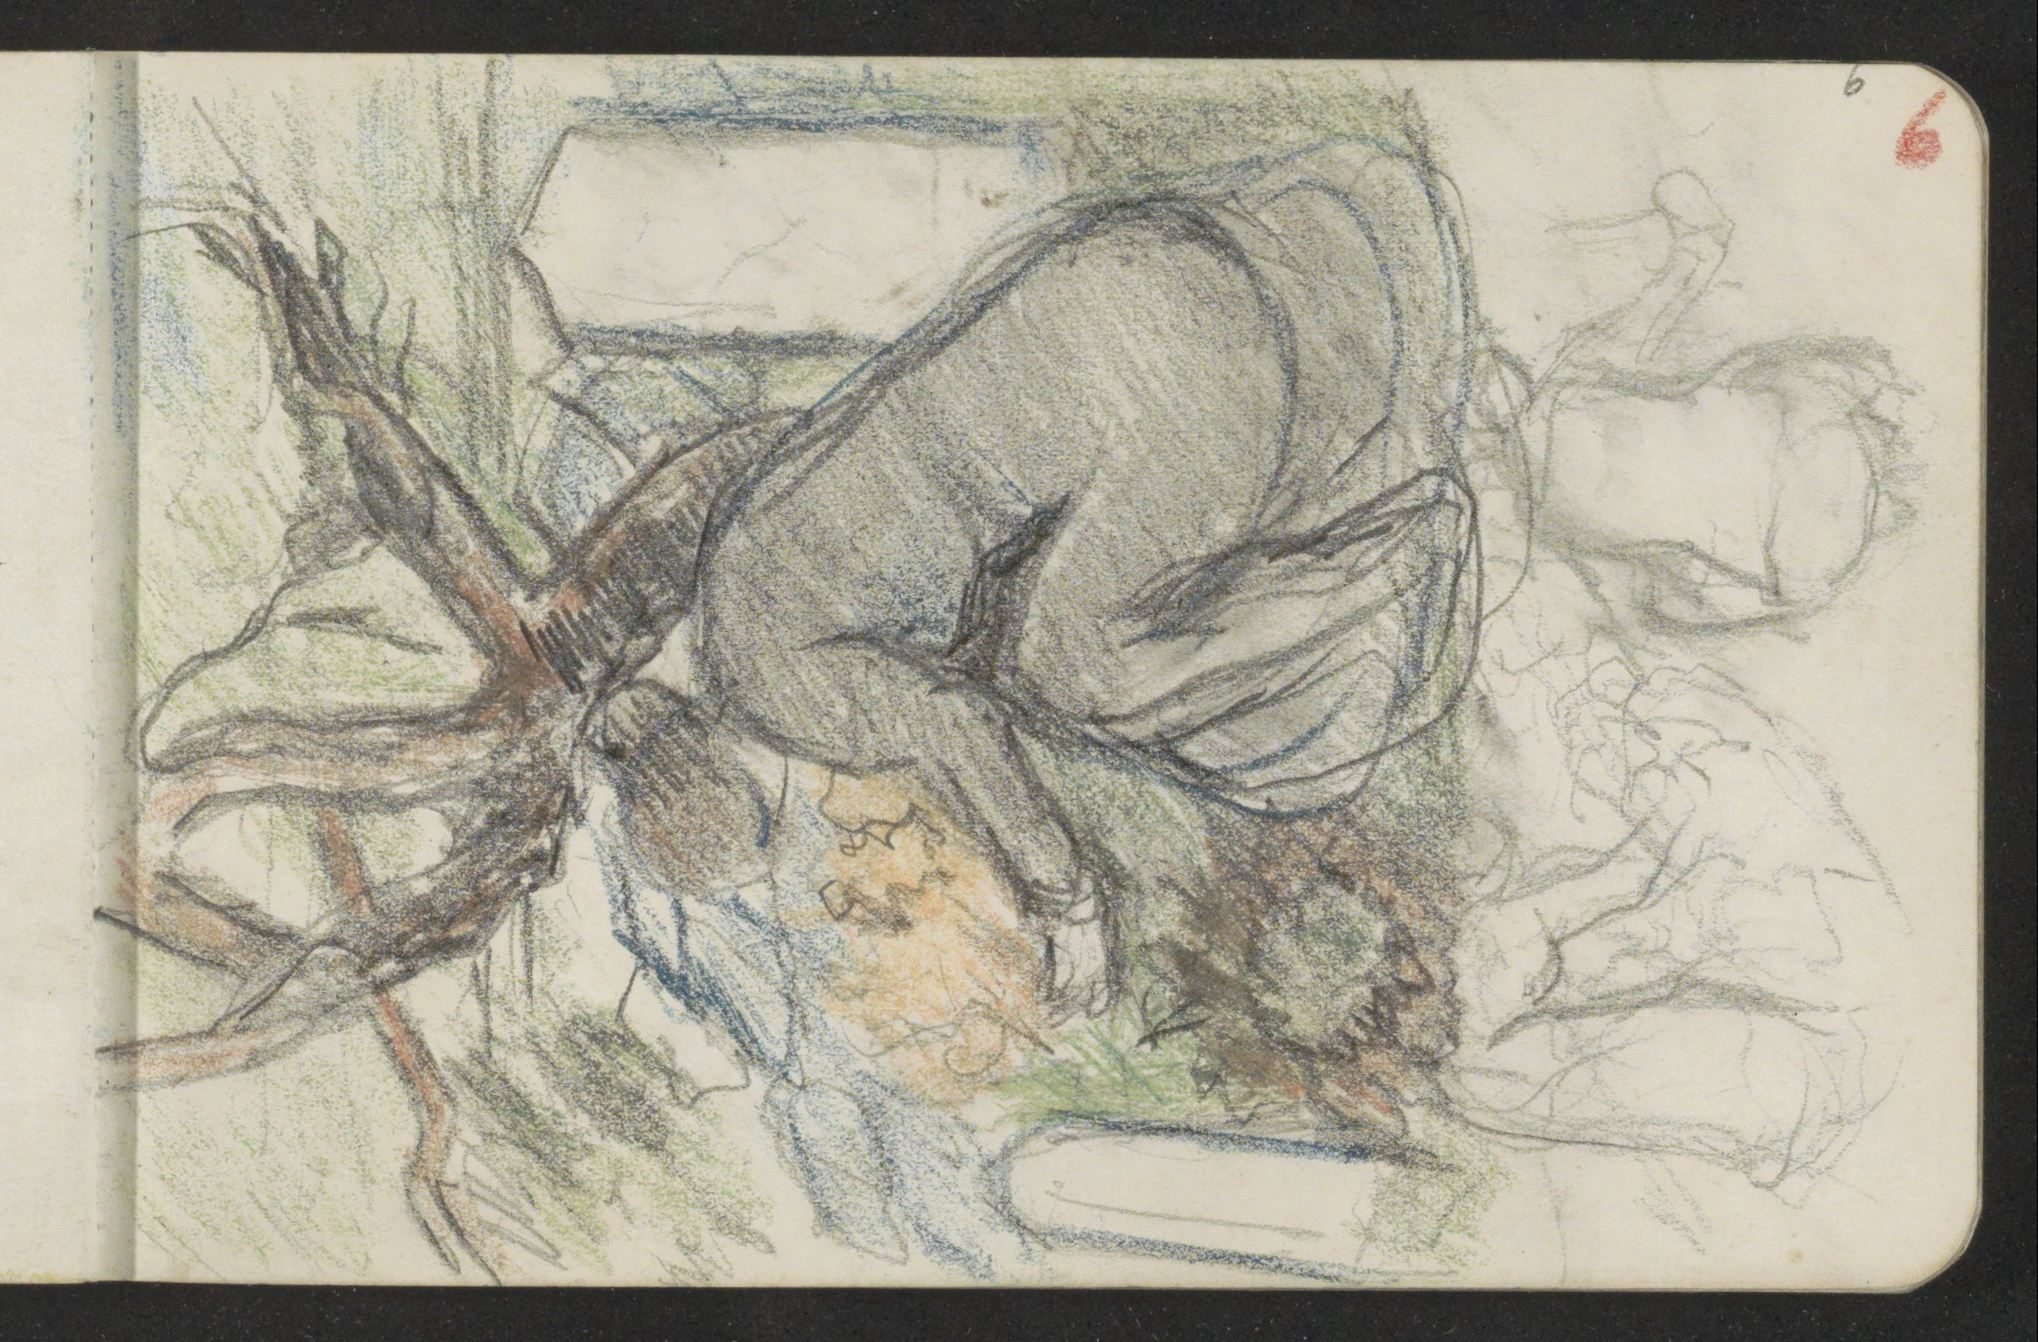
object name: sketchbook leaf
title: Hurkende vrouw bij een graf in Pontresina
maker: jozef israëls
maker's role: draughtsman, painter, print maker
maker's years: 1824-1911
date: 1869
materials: chalk, paper, pencil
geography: pontresina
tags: upright gravestone, garland, wreath, squatting, crouching figure - aa - female human figure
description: De vrouw heeft bloemen in haar handen. Op de grond ligt een krans en achter de vrouw is een boom te zien. Blad 6 recto uit een schetsboek met 36 bladen.